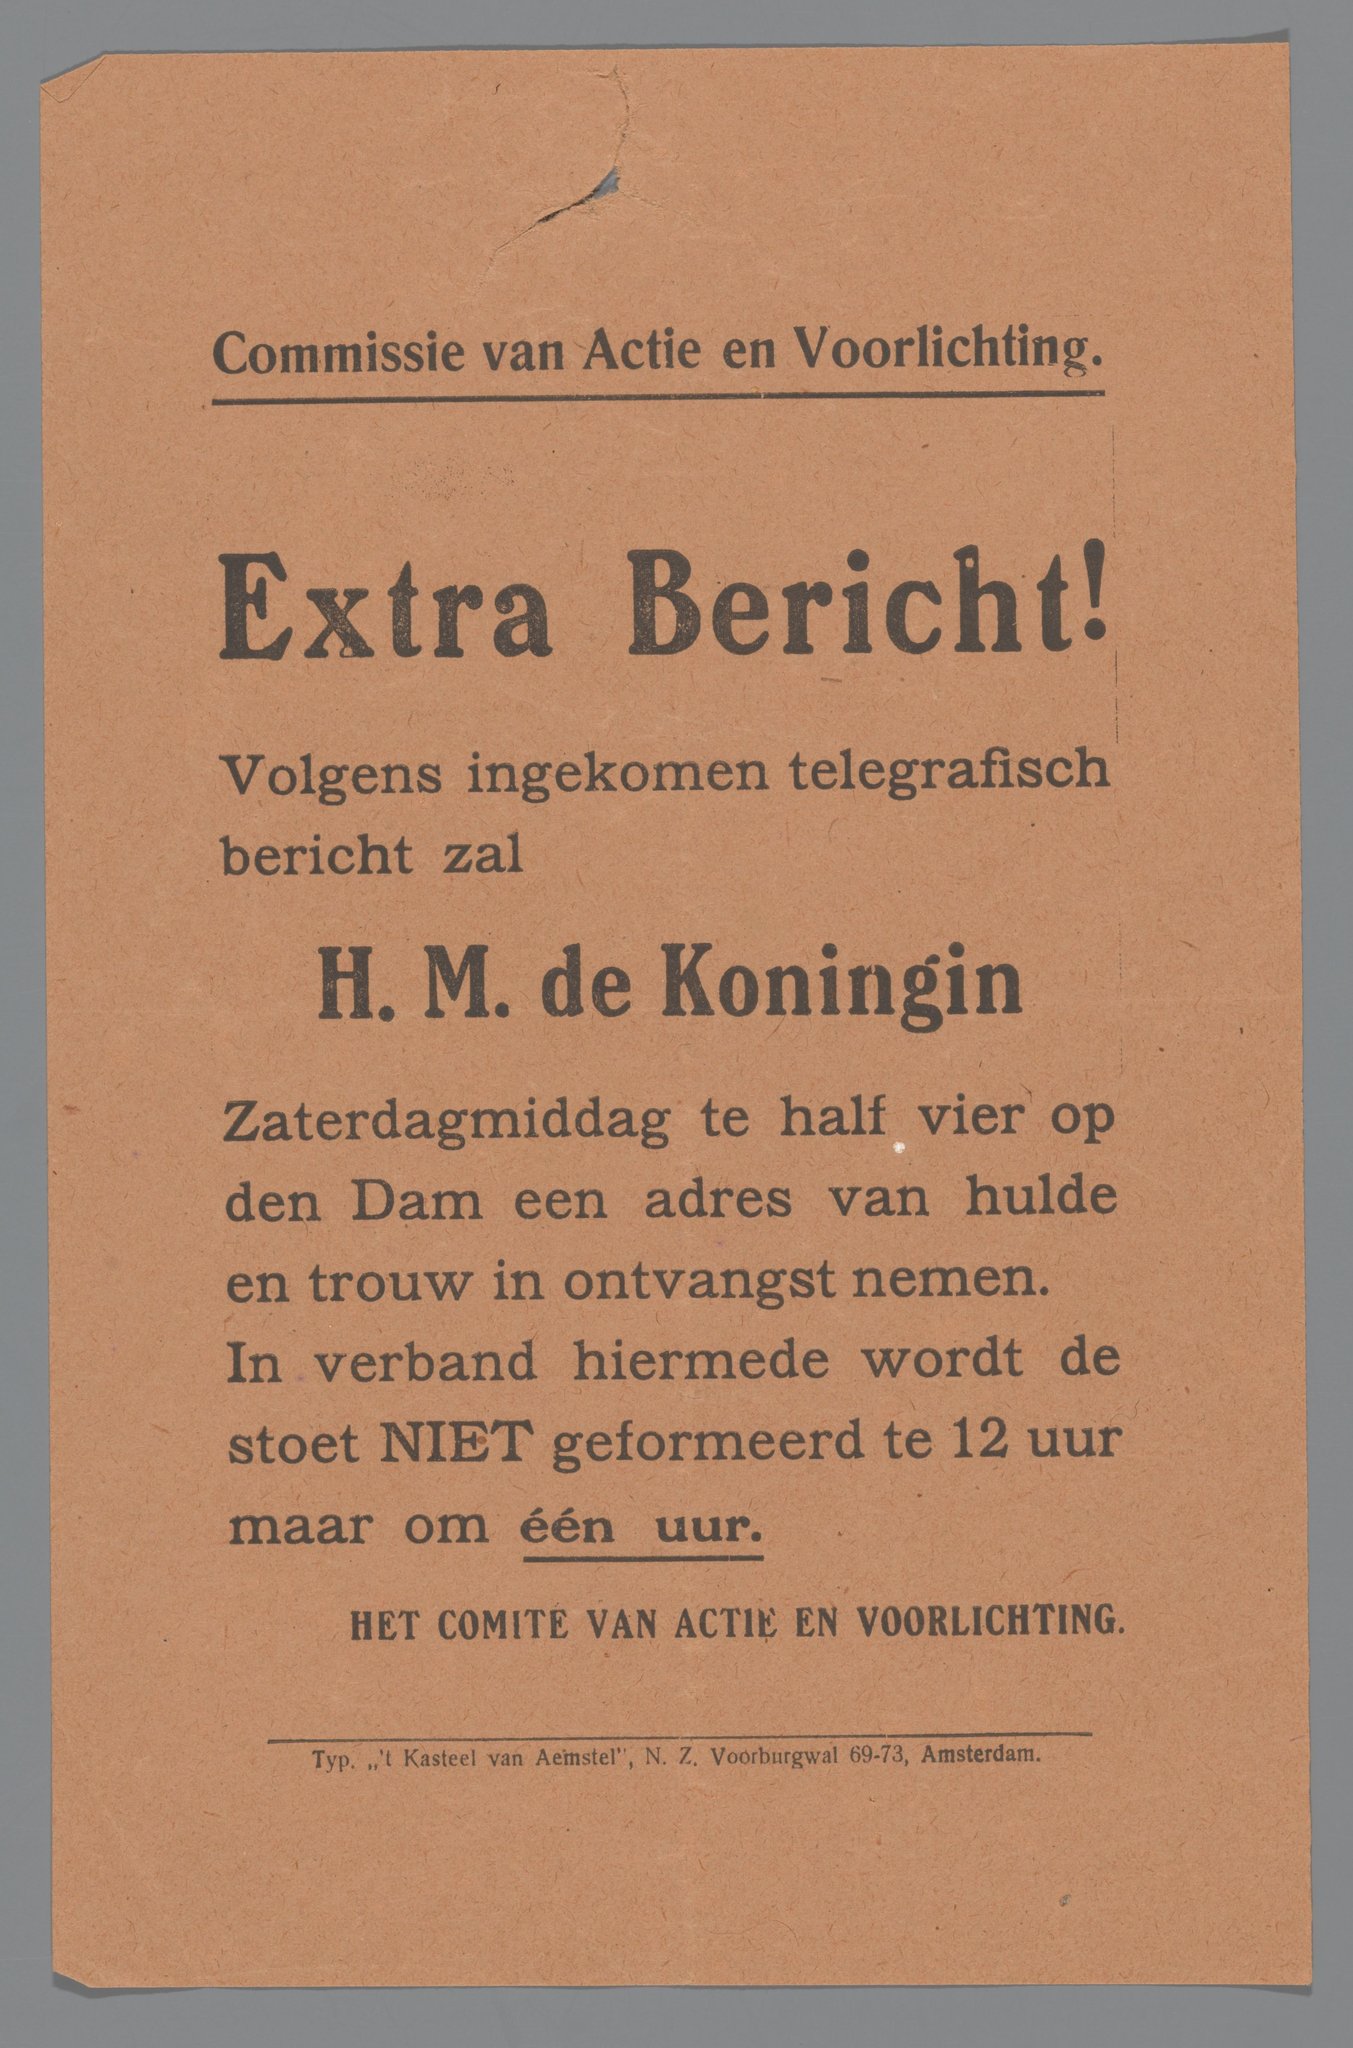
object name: pamphlet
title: Nationale Betooging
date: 1918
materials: paper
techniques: printing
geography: amsterdam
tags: the hague, wilhelmina of the netherlands, amsterdam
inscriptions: date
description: Oranje-kleurig, eenzijdig bedrukt vel papier, waarin de komst van de koningin wordt meegedeeld. Opschrift; b.: 'Commissie van Actie en Voorlichting'. Gedateerd: 23-11-1918.